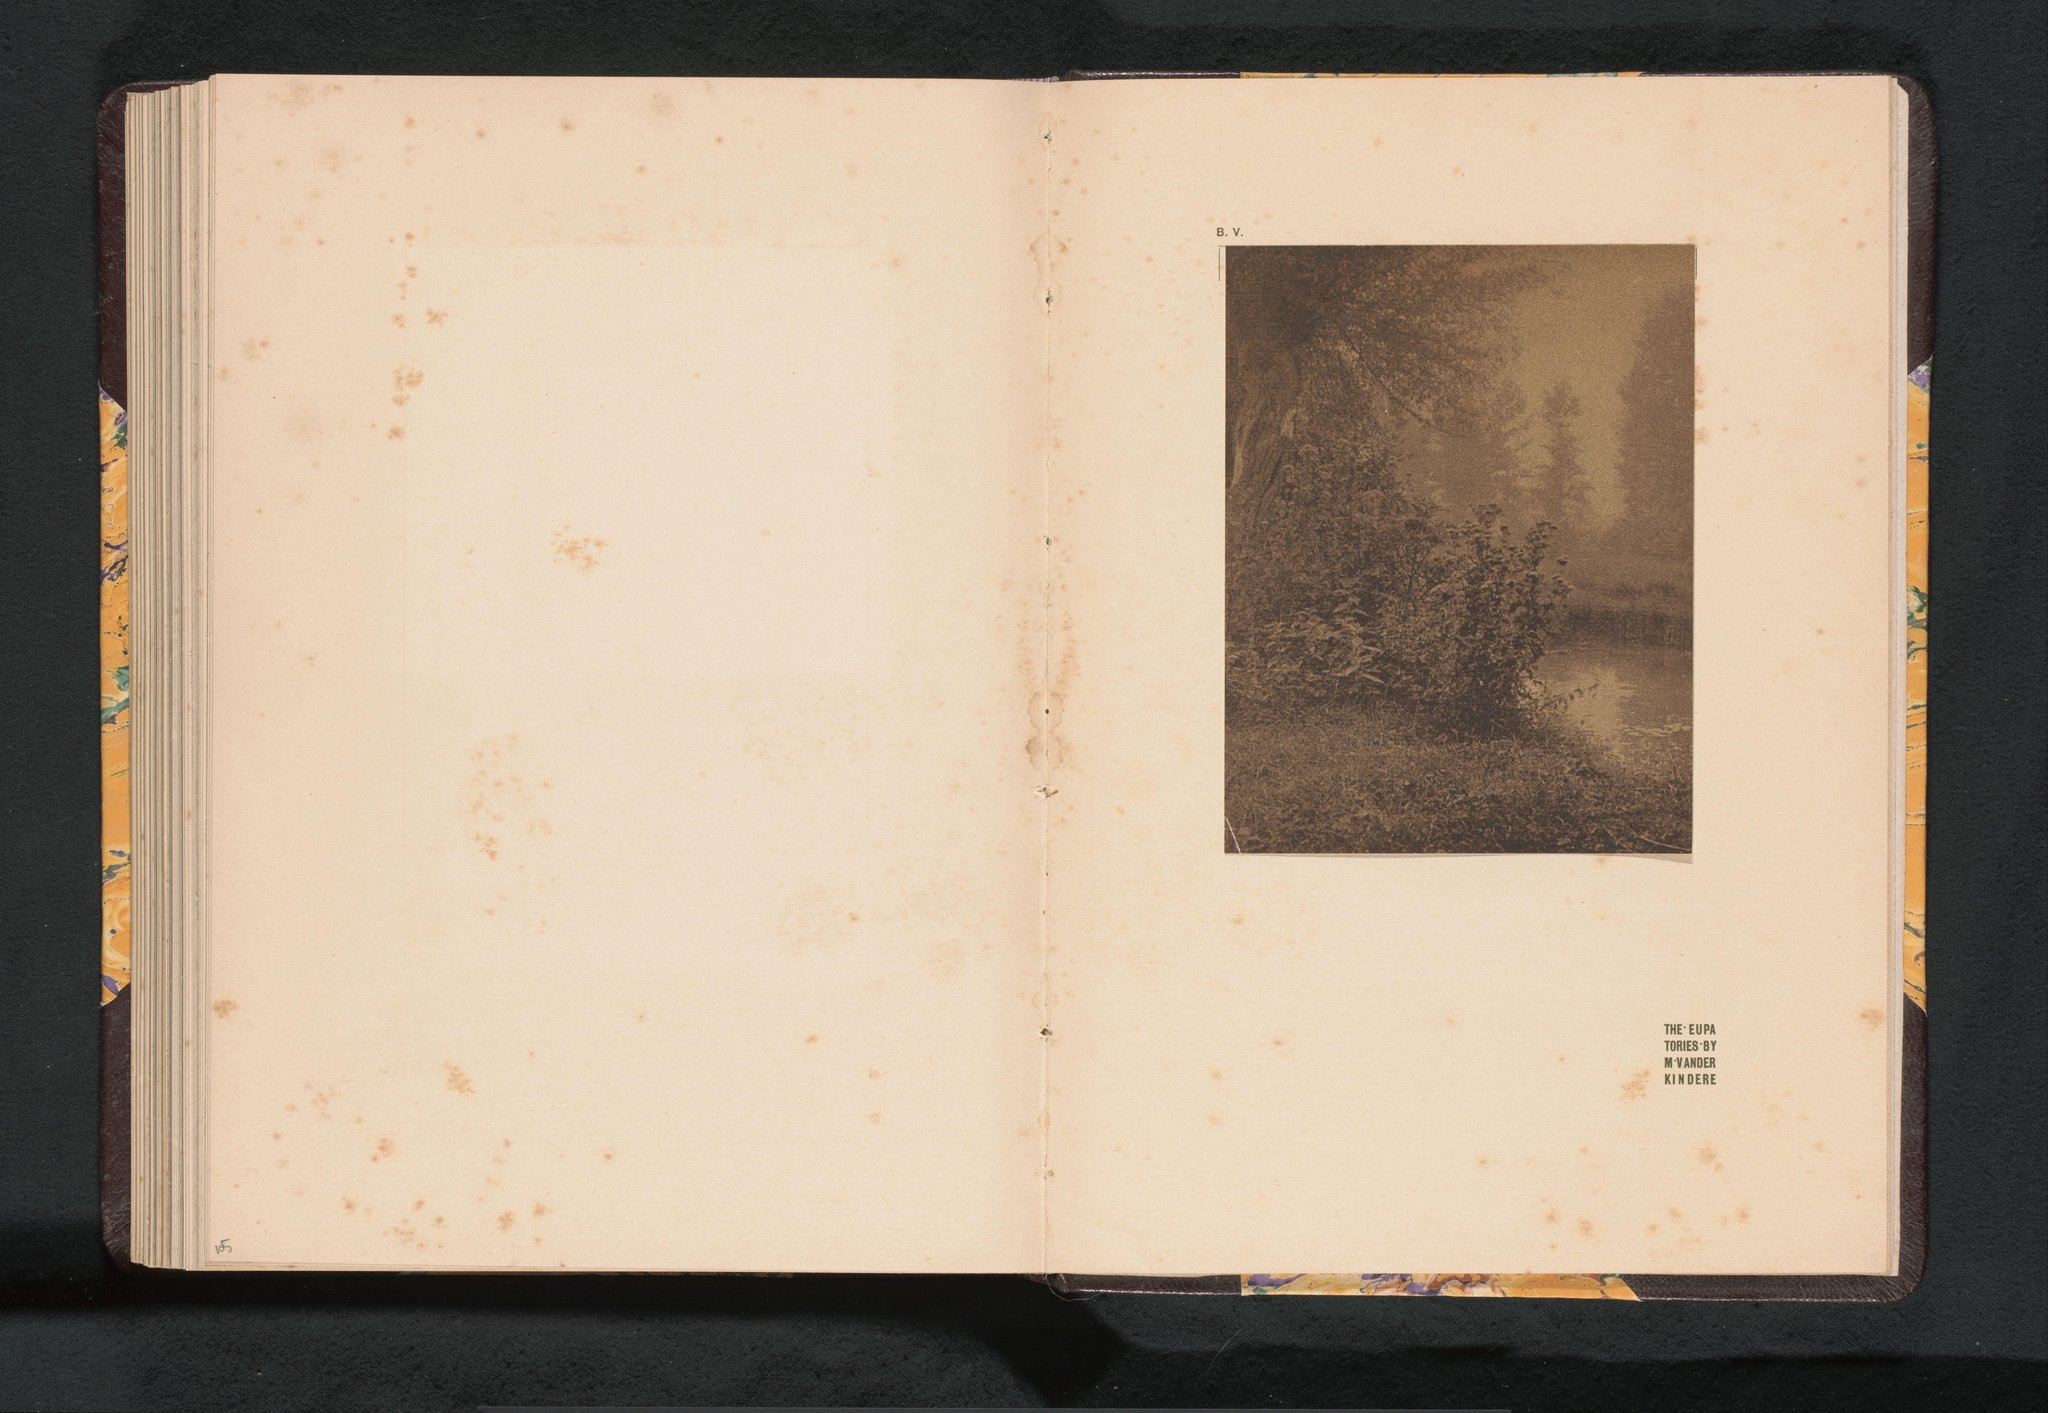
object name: photomechanical print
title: Landschap met koninginnekruid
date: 1900-1905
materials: paper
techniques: collo-autotype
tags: plants and herbs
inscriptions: inscription: ‘The Eupatories by M. Vanderkindere’, inscription: ‘B. V.’